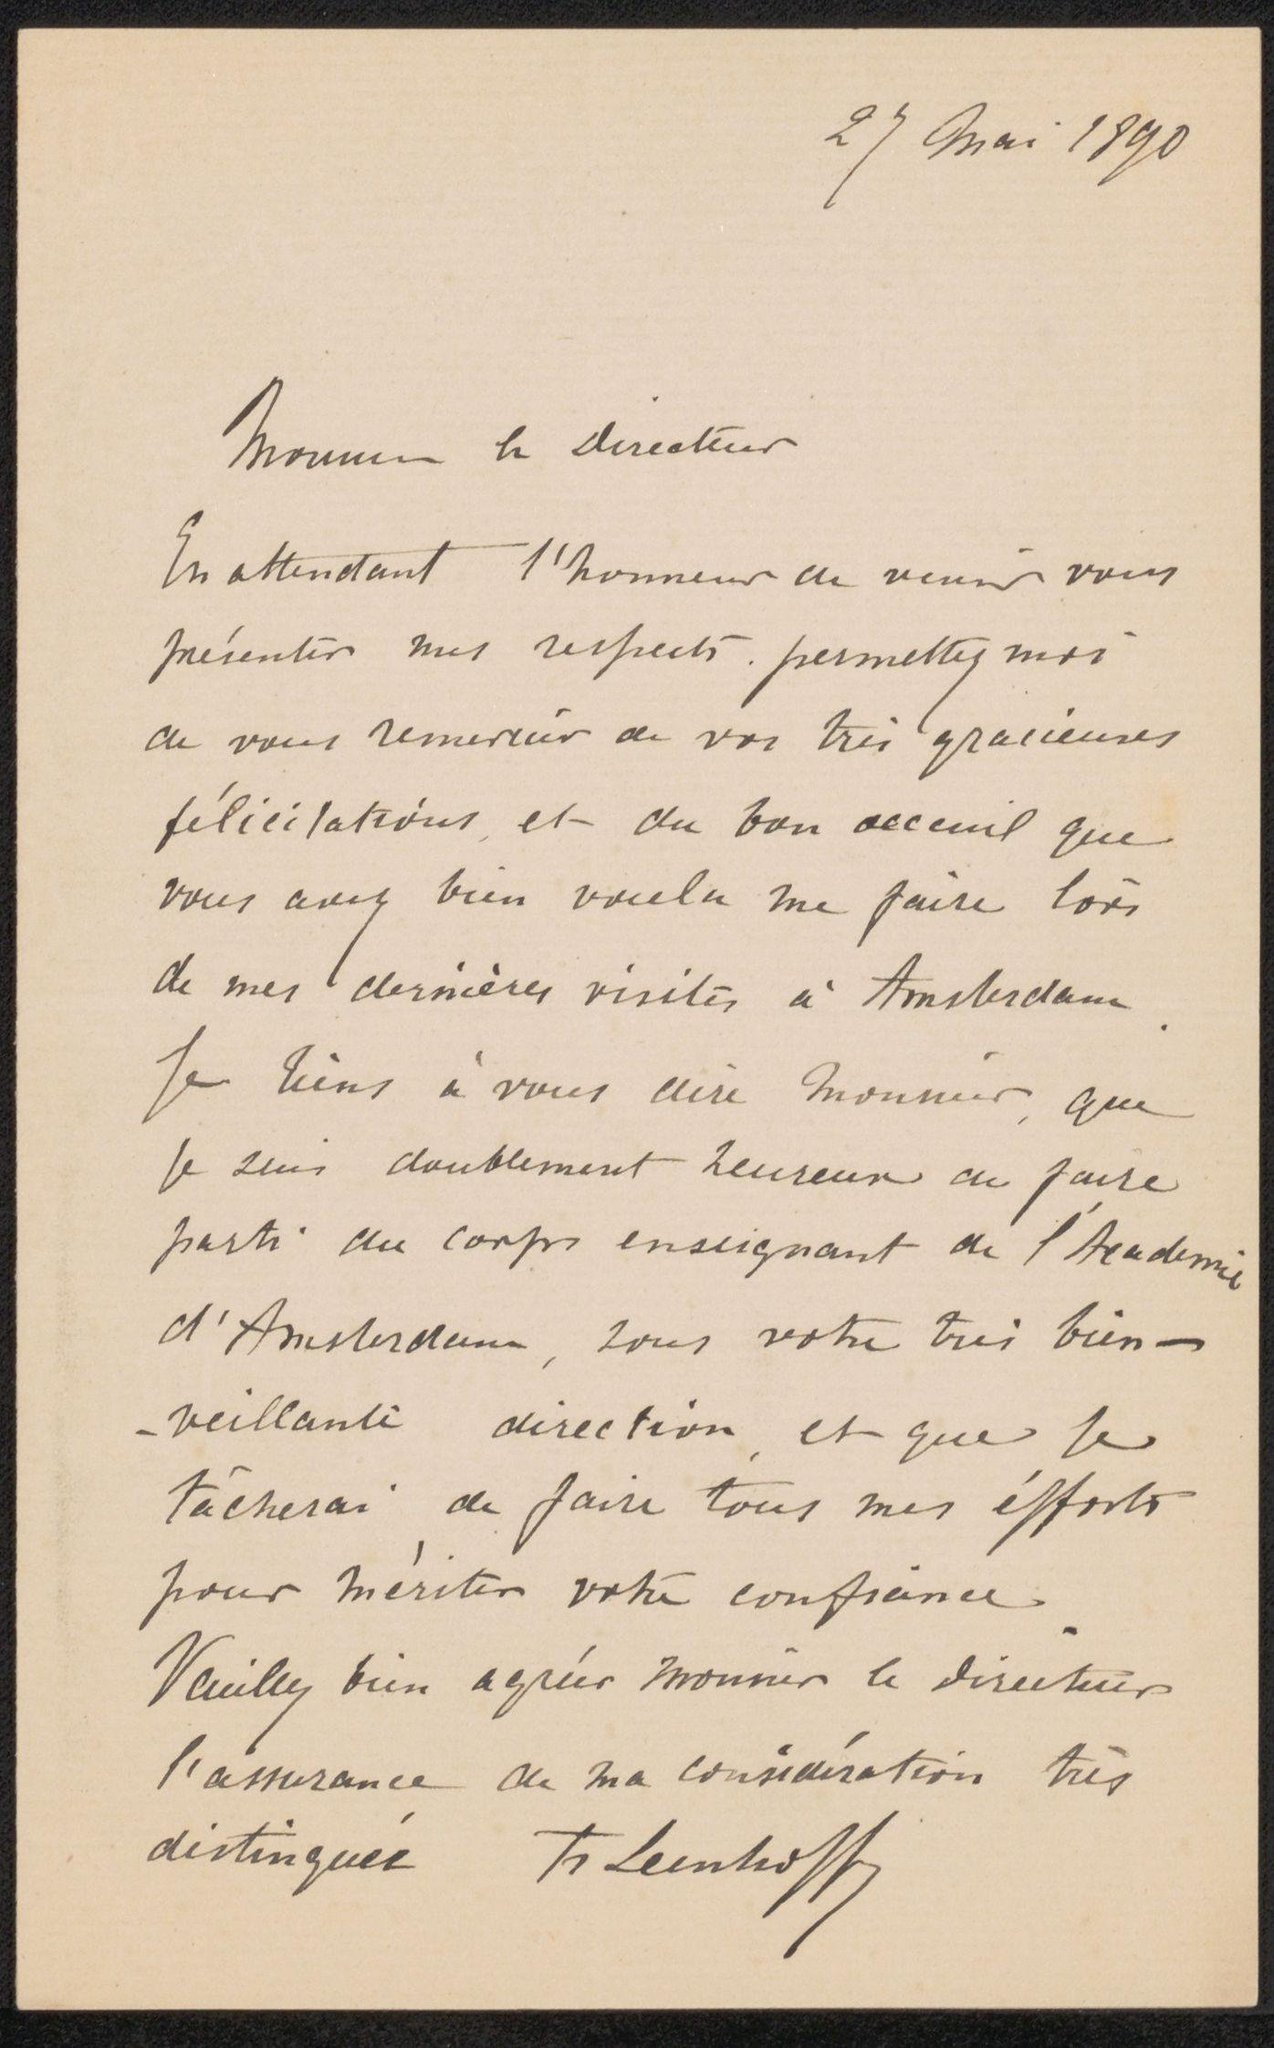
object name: letter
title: Brief aan August Allebé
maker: ferdinand leenhoff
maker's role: print maker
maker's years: 1841-1914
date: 1890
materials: ink, paper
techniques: pen, writing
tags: draughtsman, august allebé, amsterdam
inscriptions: watermark